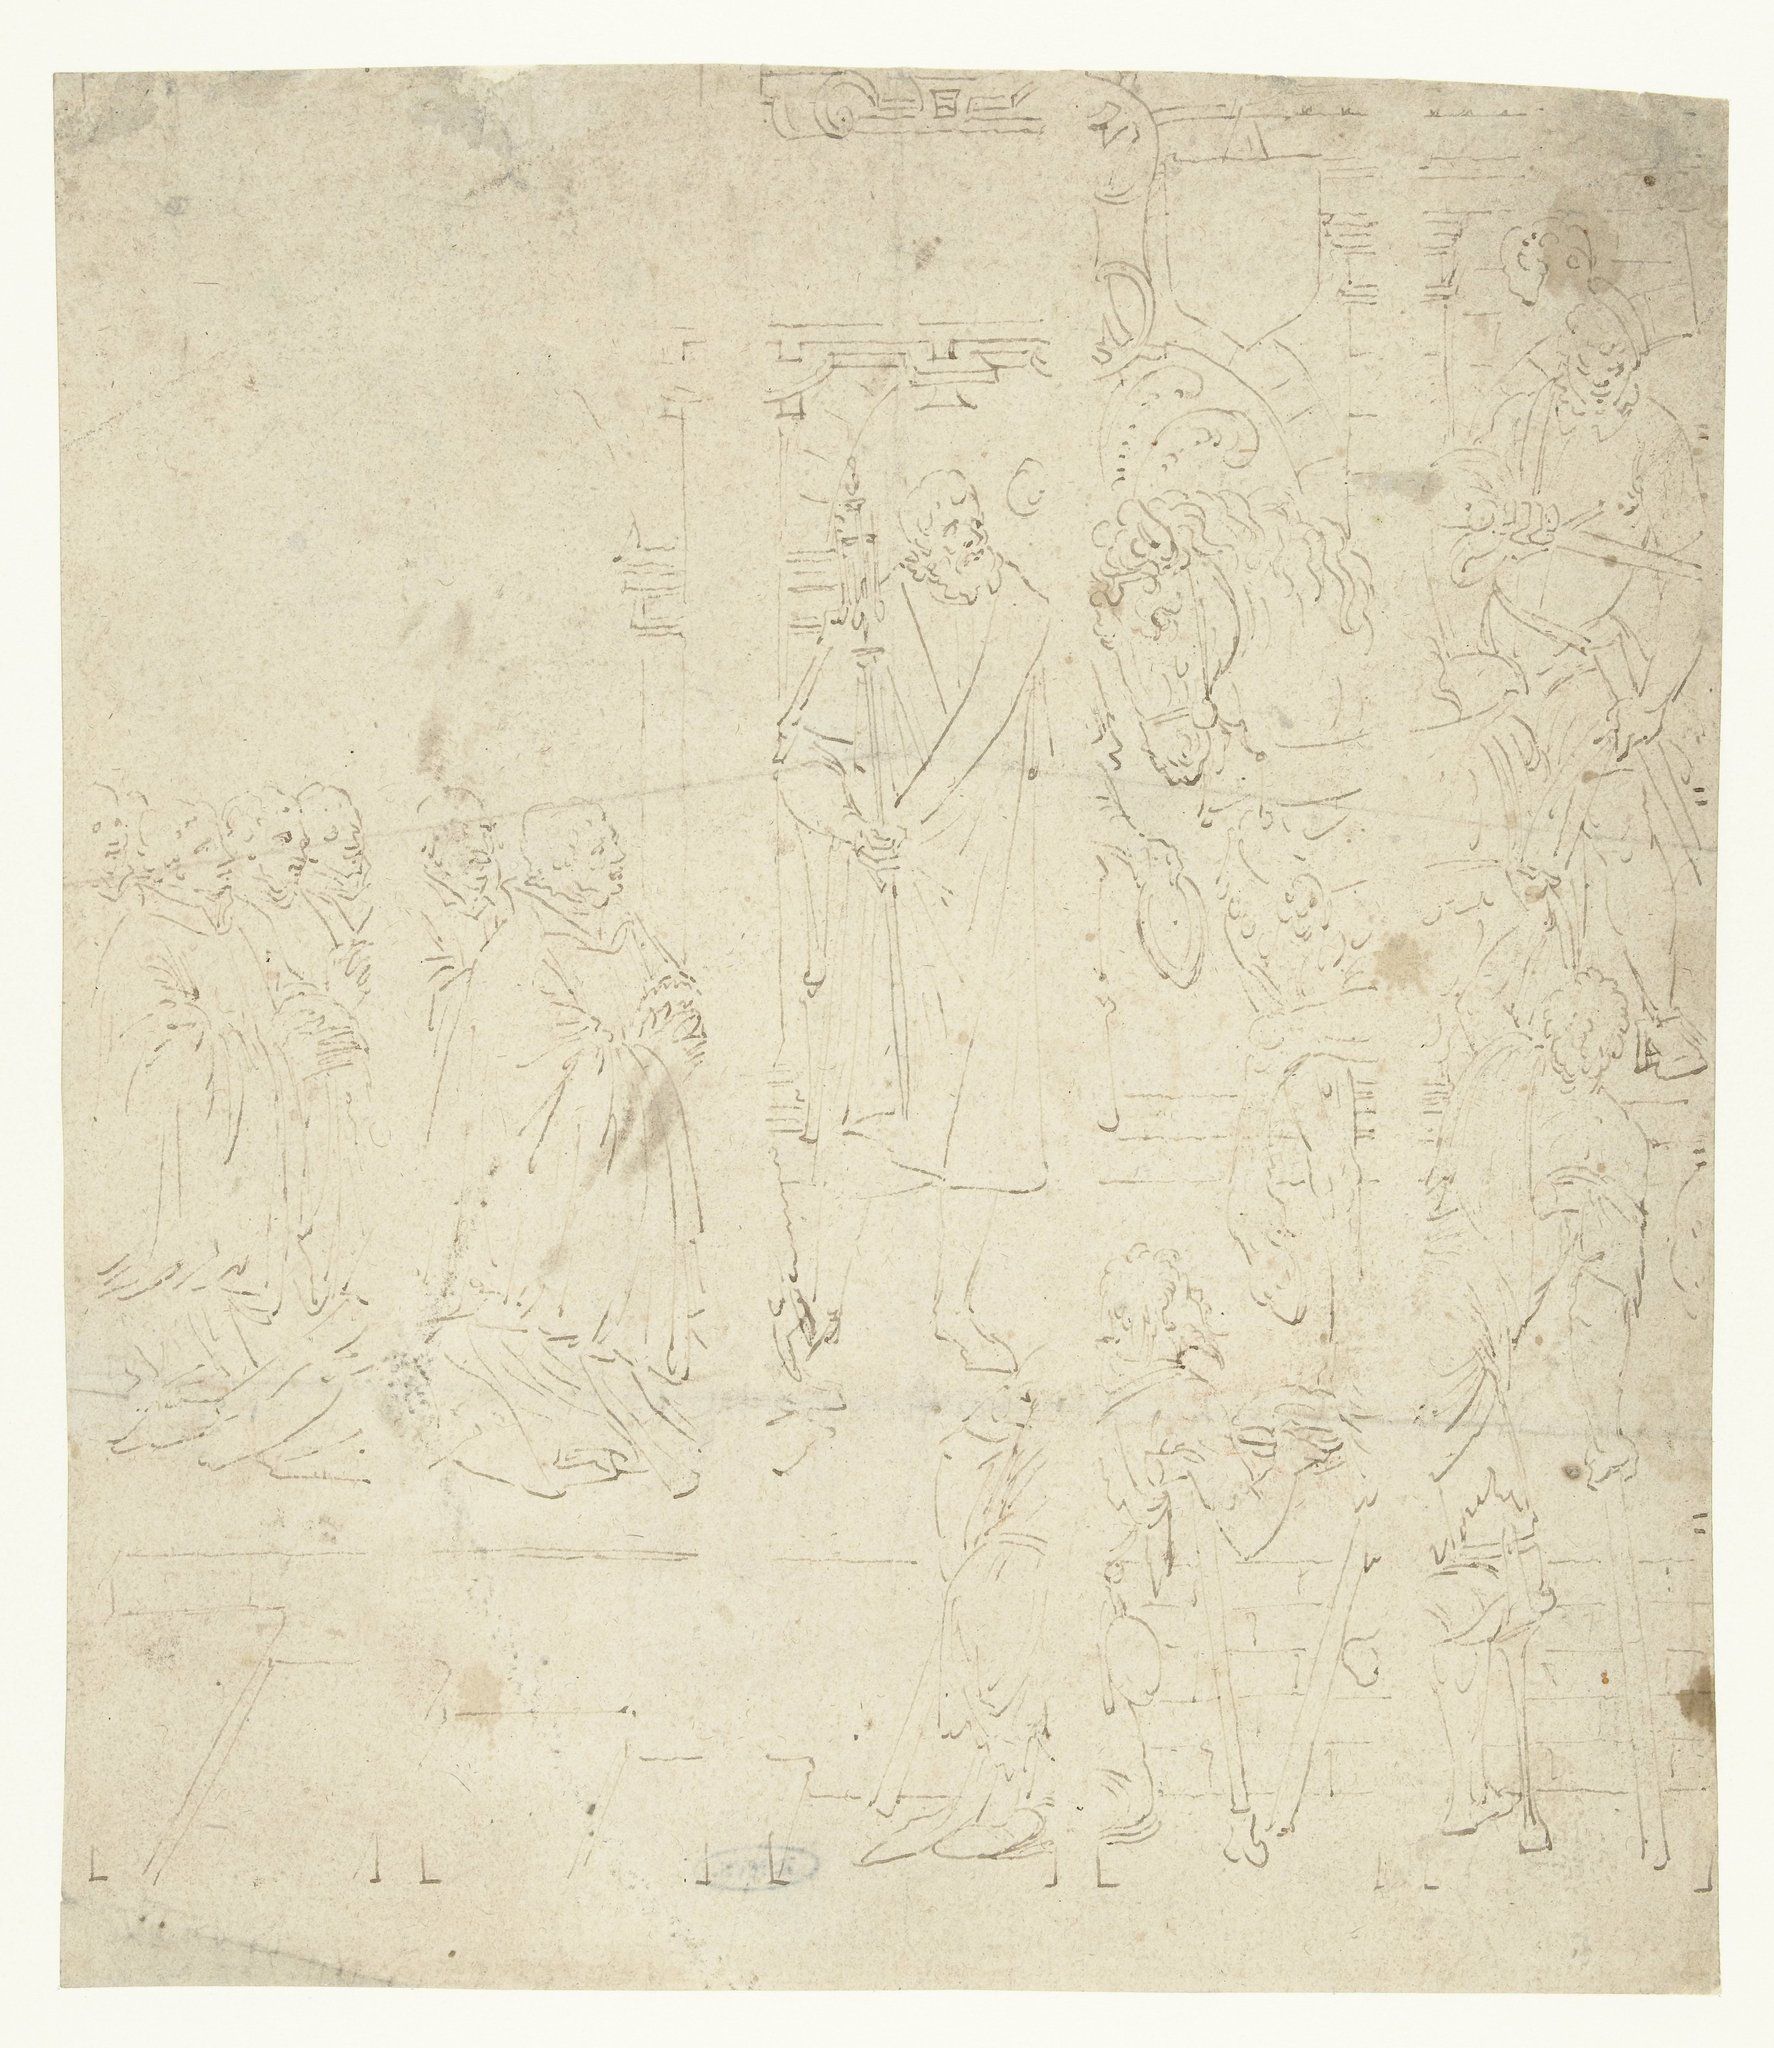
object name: drawing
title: Heilige Martinus en diakenen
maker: dirck pietersz. crabeth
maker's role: draughtsman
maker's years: 1520-1574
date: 1545-1574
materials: ink, paper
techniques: pen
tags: st. martin divides his cloak (i.e. the charity of st. martin): he is usually shown on horseback, cutting his cloak with his sword, or putting part of the cloak round the shoulders of a beggar who kneels beside him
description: Ontwerptekening voor een glasraam voorstellende de heilige Martinus en enkele diakenen als schenkers.